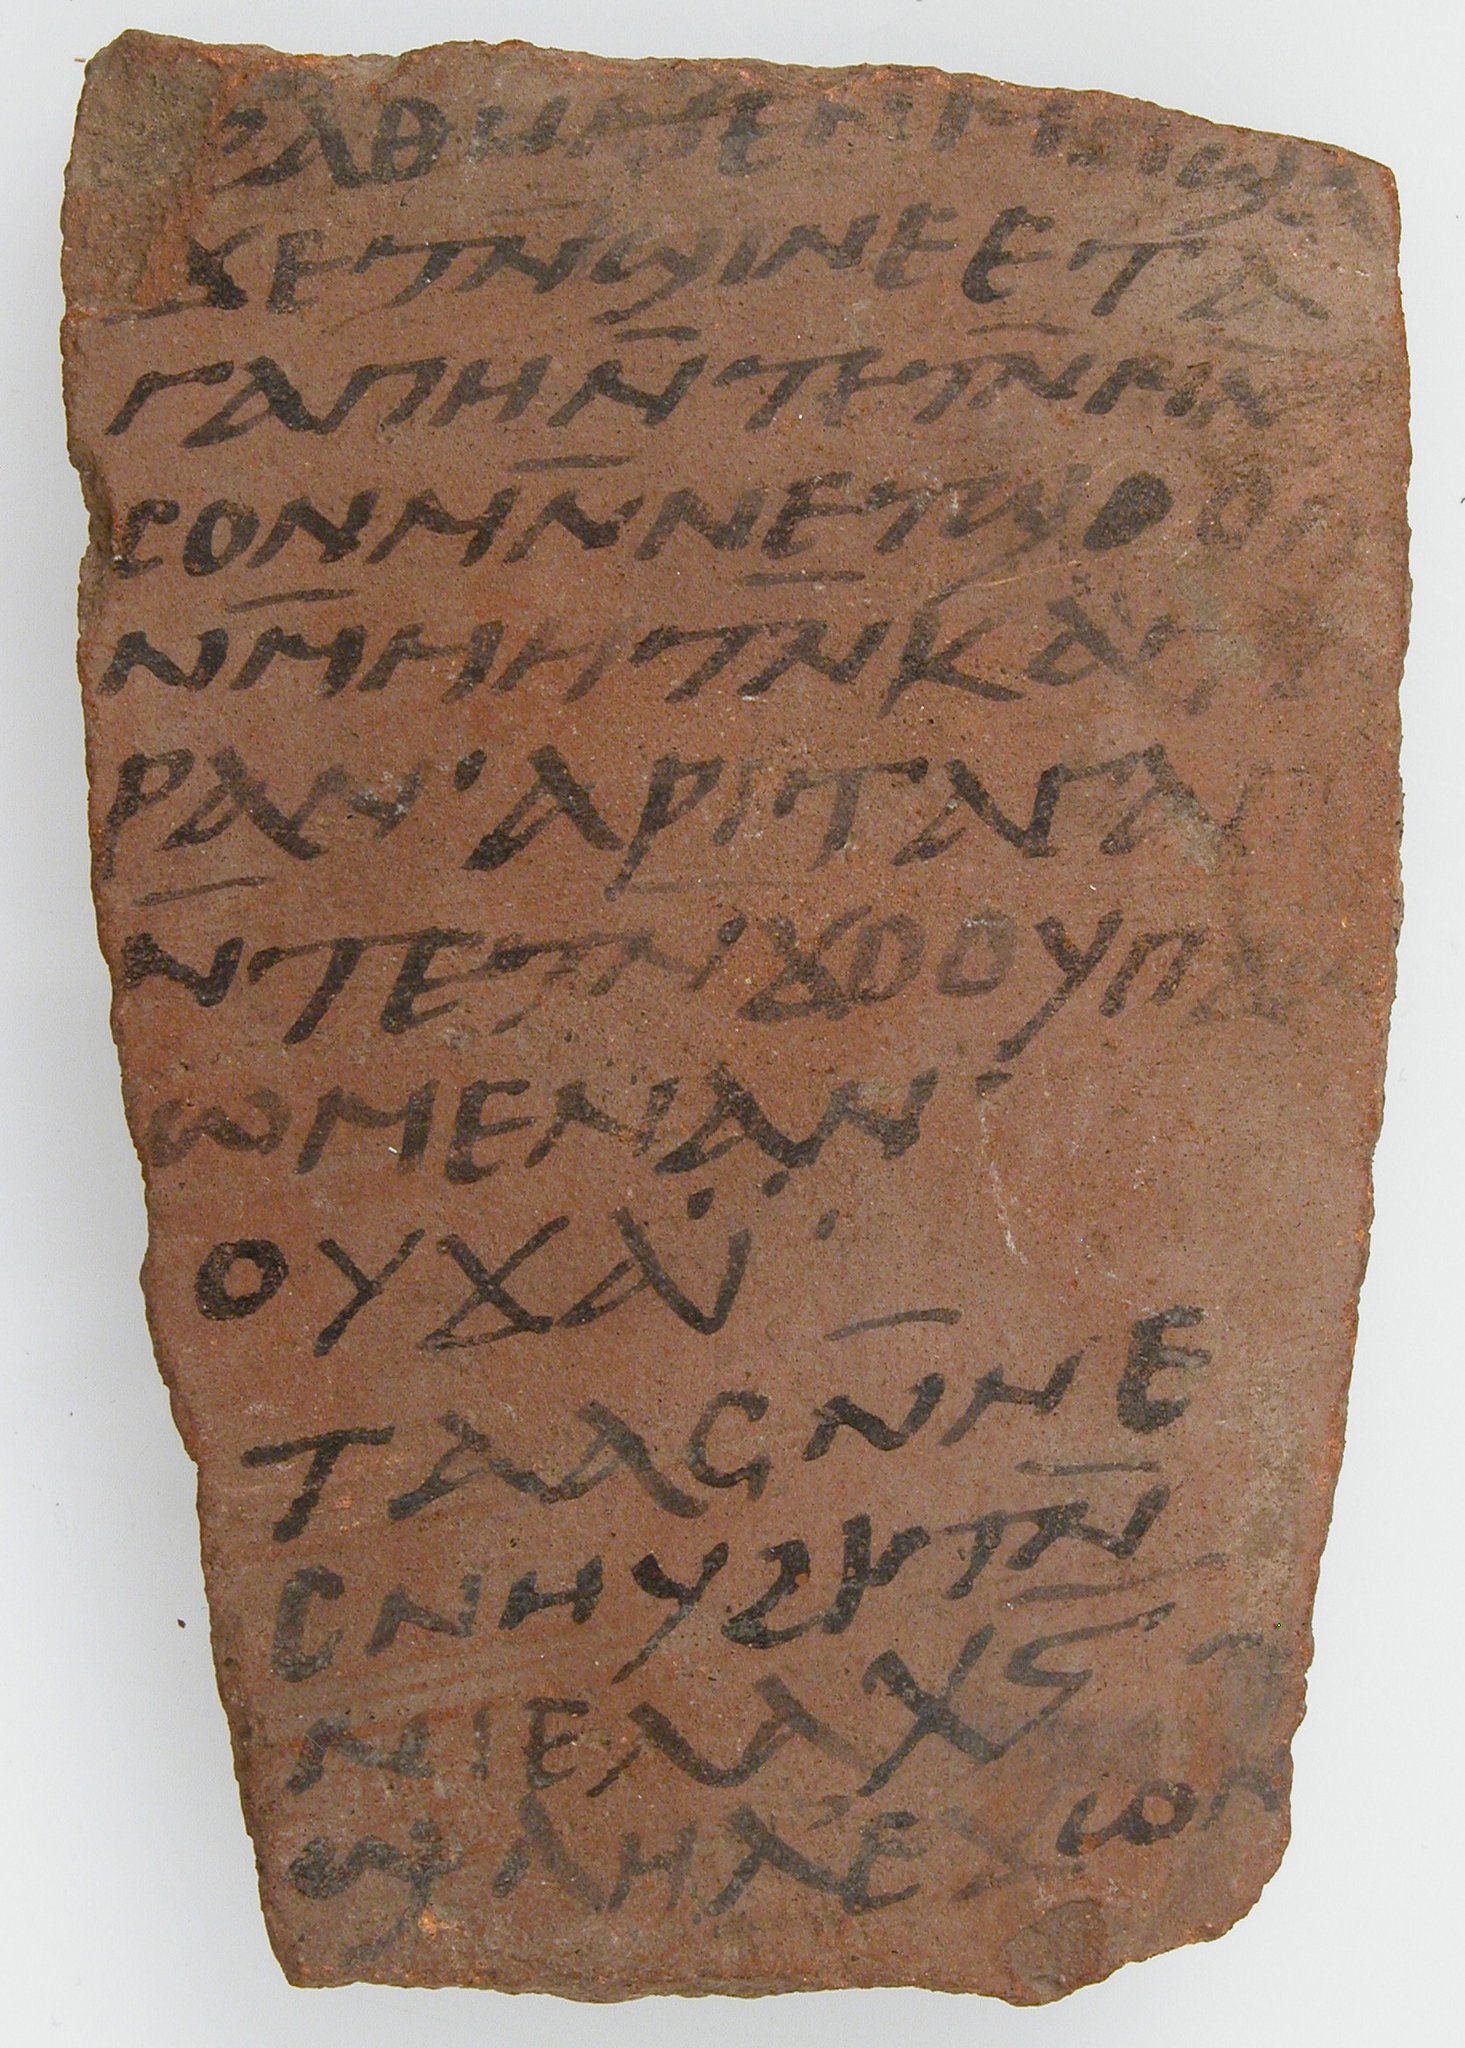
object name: ostrakon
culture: coptic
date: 601-700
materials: ink, pottery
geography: egypt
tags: coptic